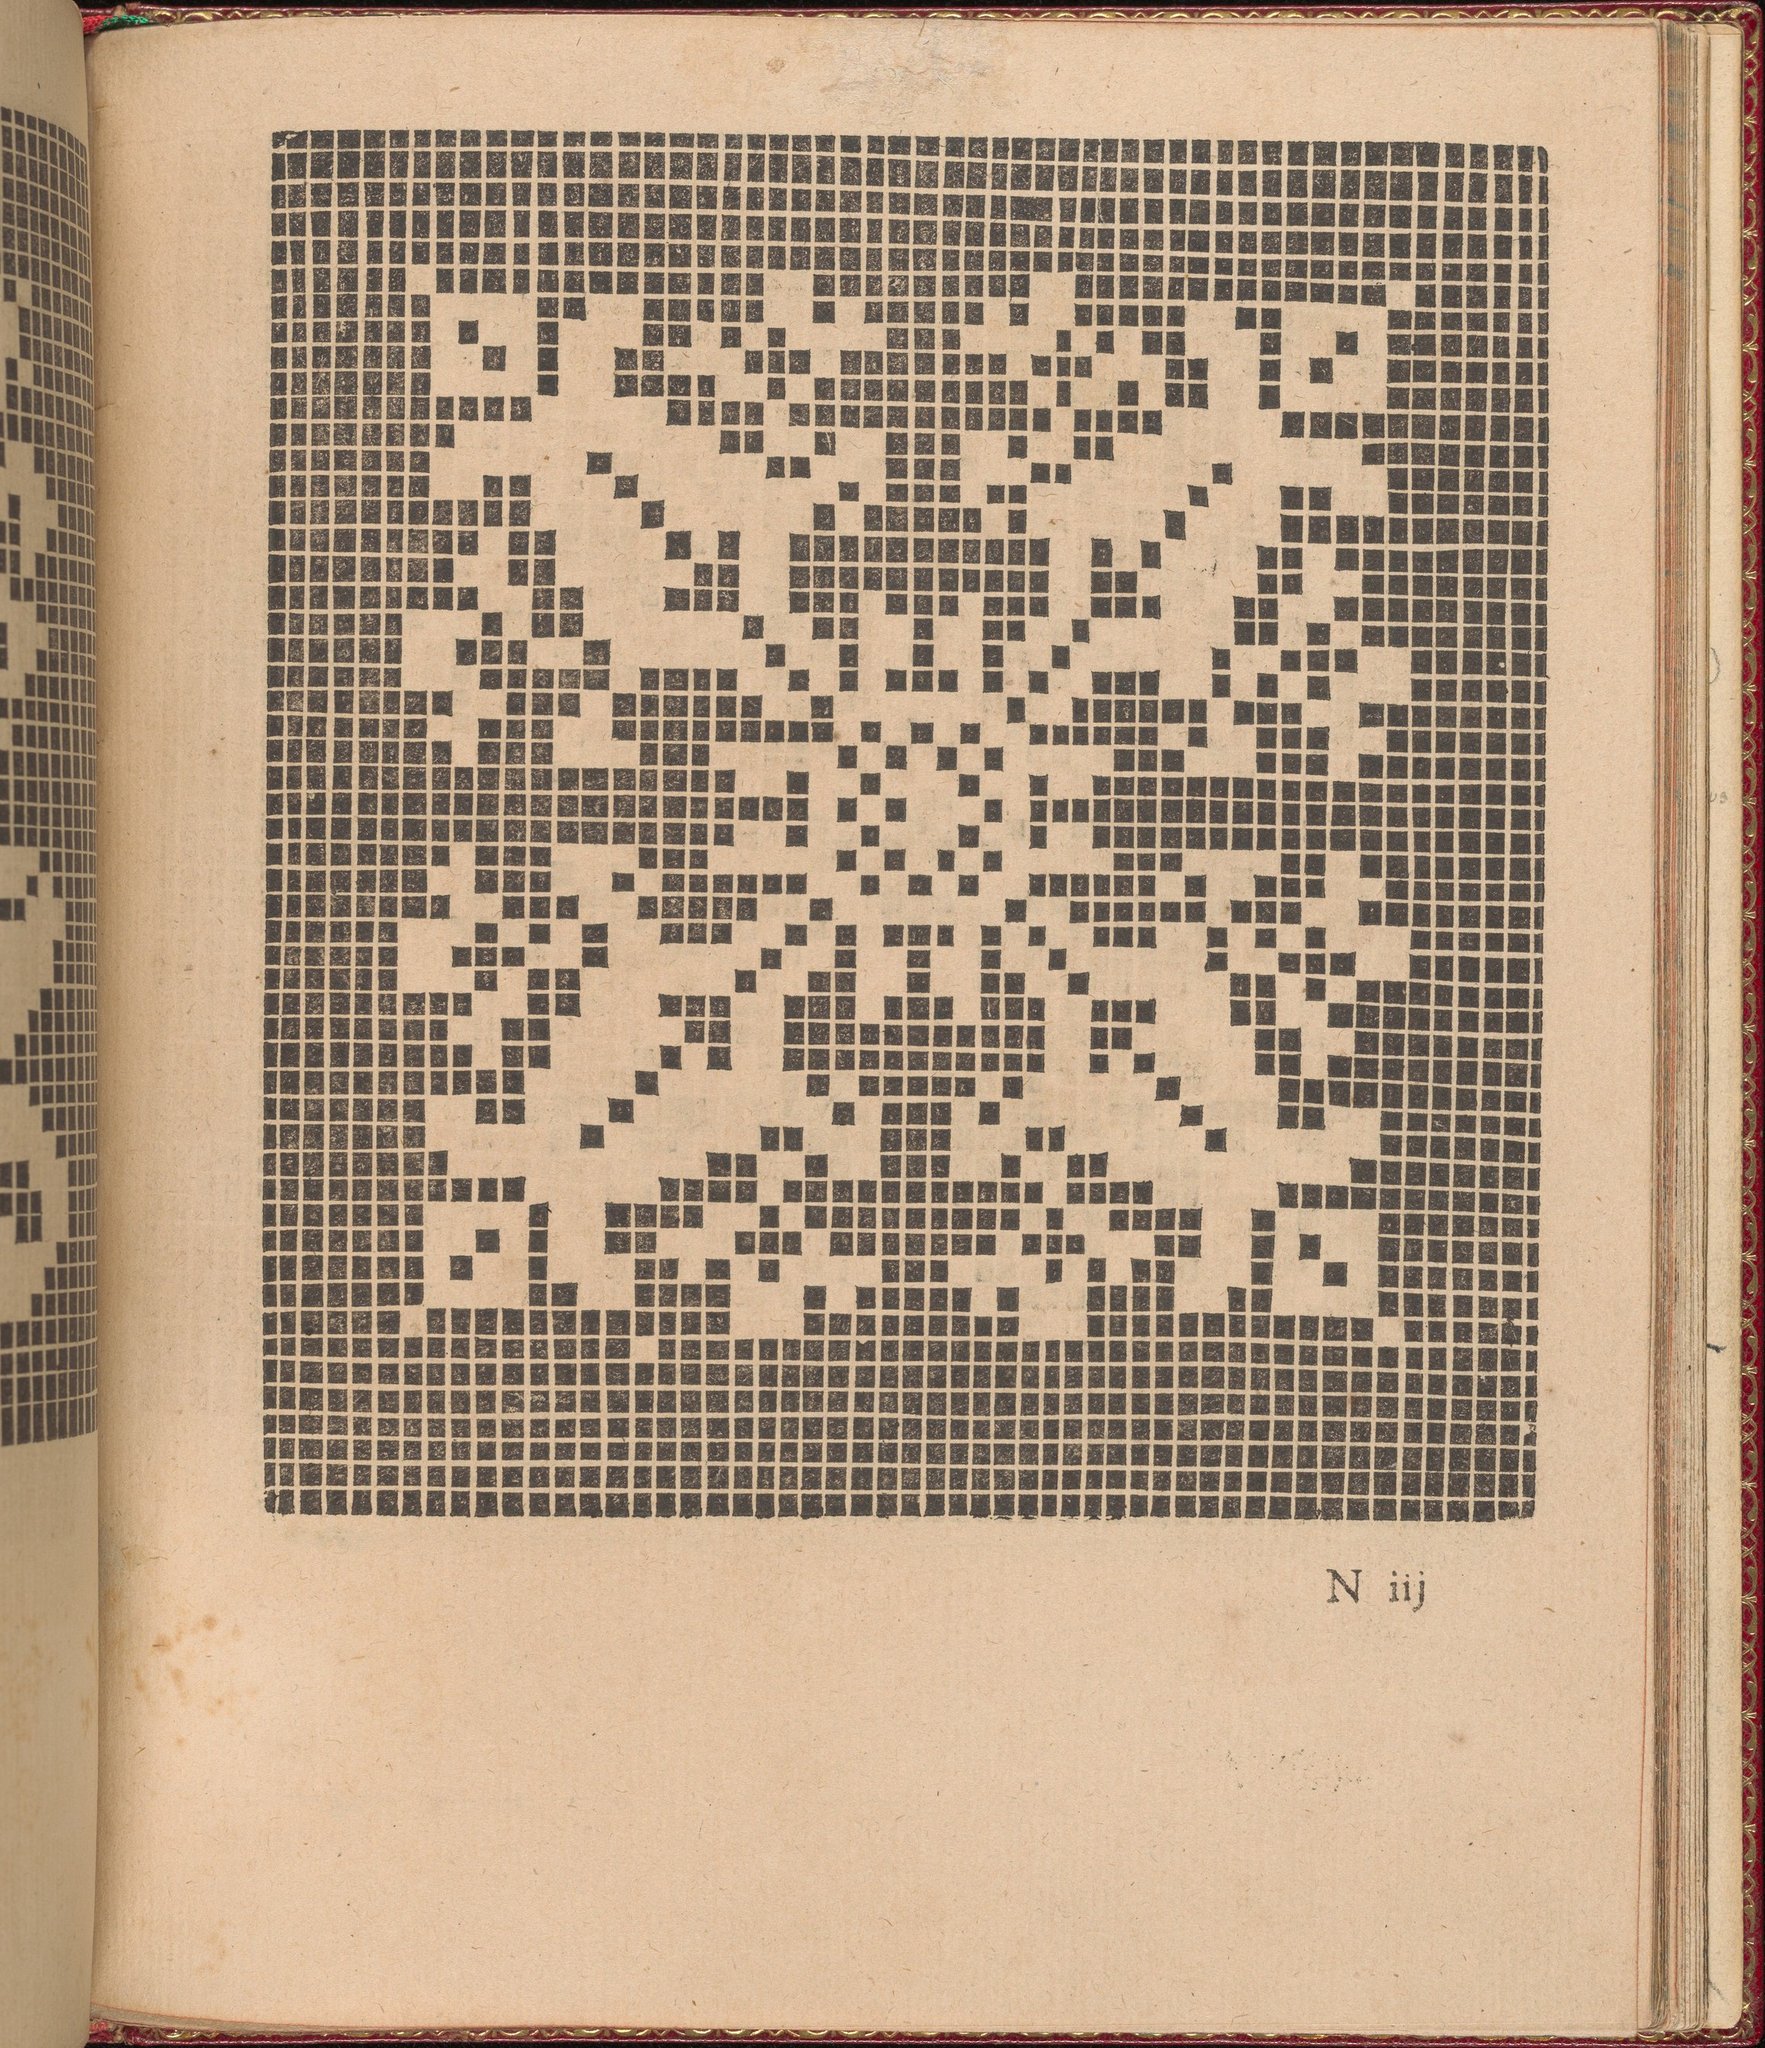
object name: book print ornament architecture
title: Les Singuliers et Nouveaux Portraicts... page 51 (recto)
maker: federico de vinciolo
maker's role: designer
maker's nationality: italian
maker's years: 1582-1599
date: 1588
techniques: woodcut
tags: flowers